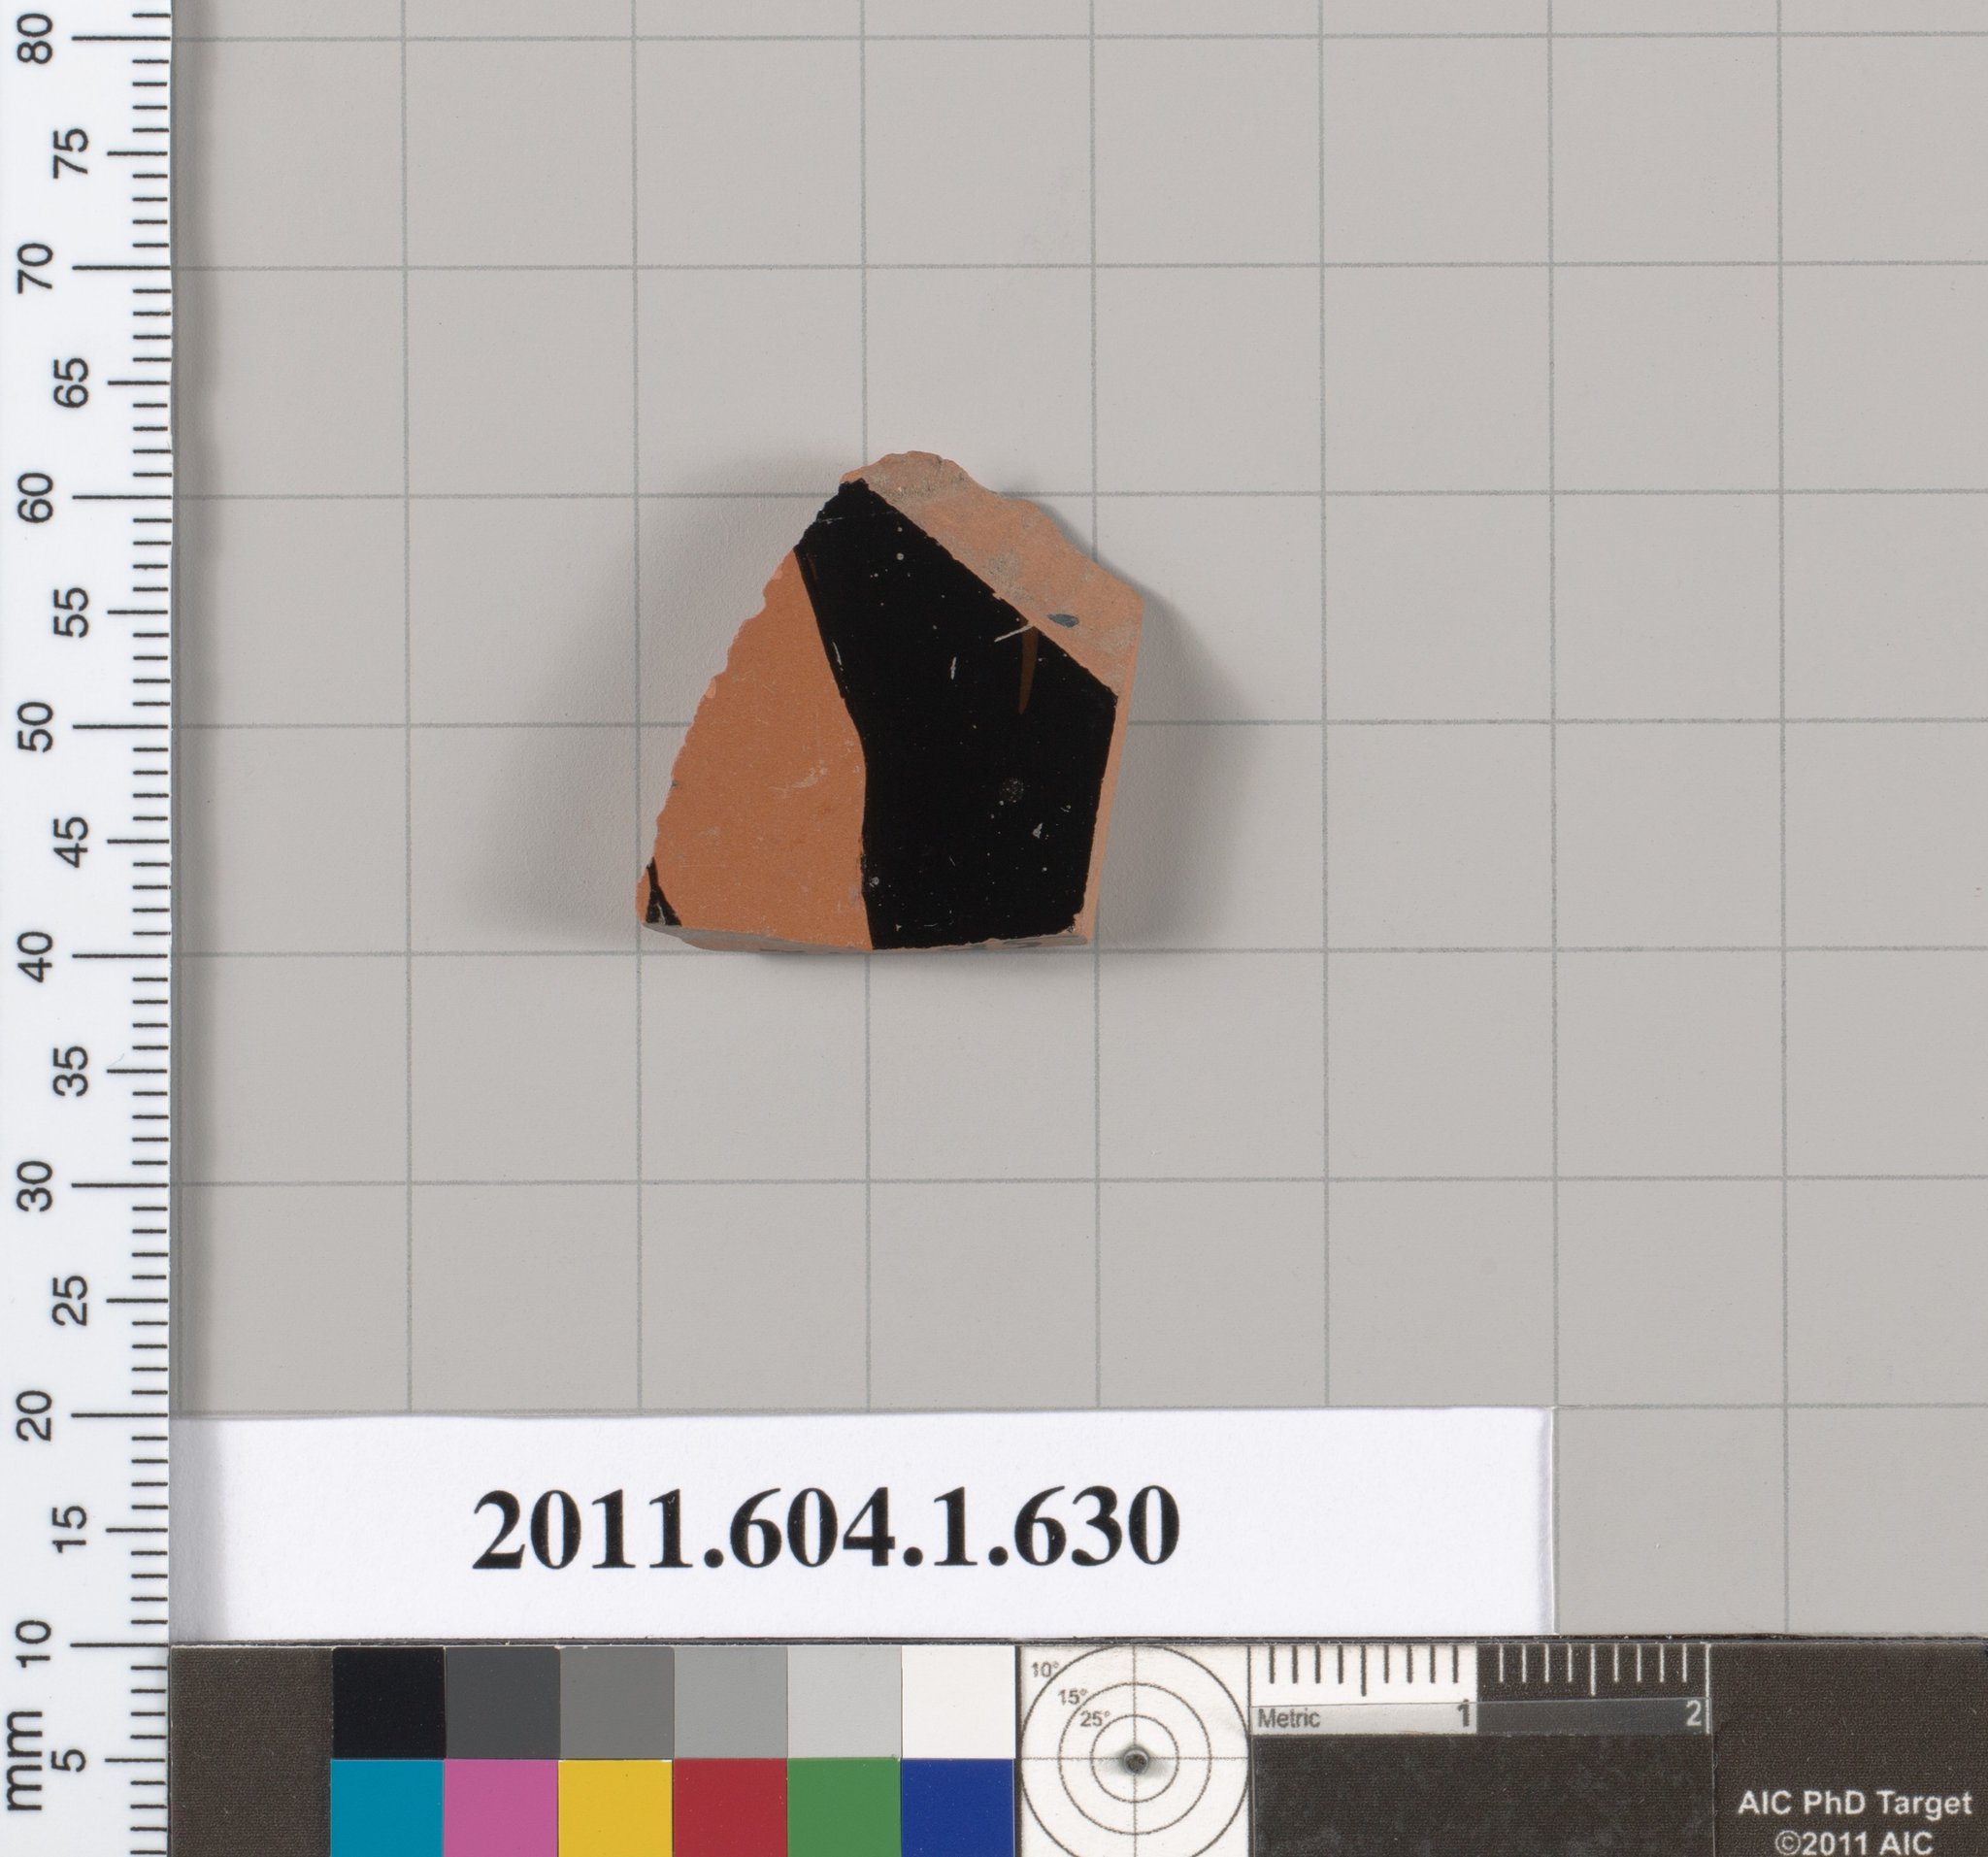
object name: kylix fragment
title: Terracotta fragment of a kylix (drinking cup)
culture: greek, attic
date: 475-451 BCE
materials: terracotta